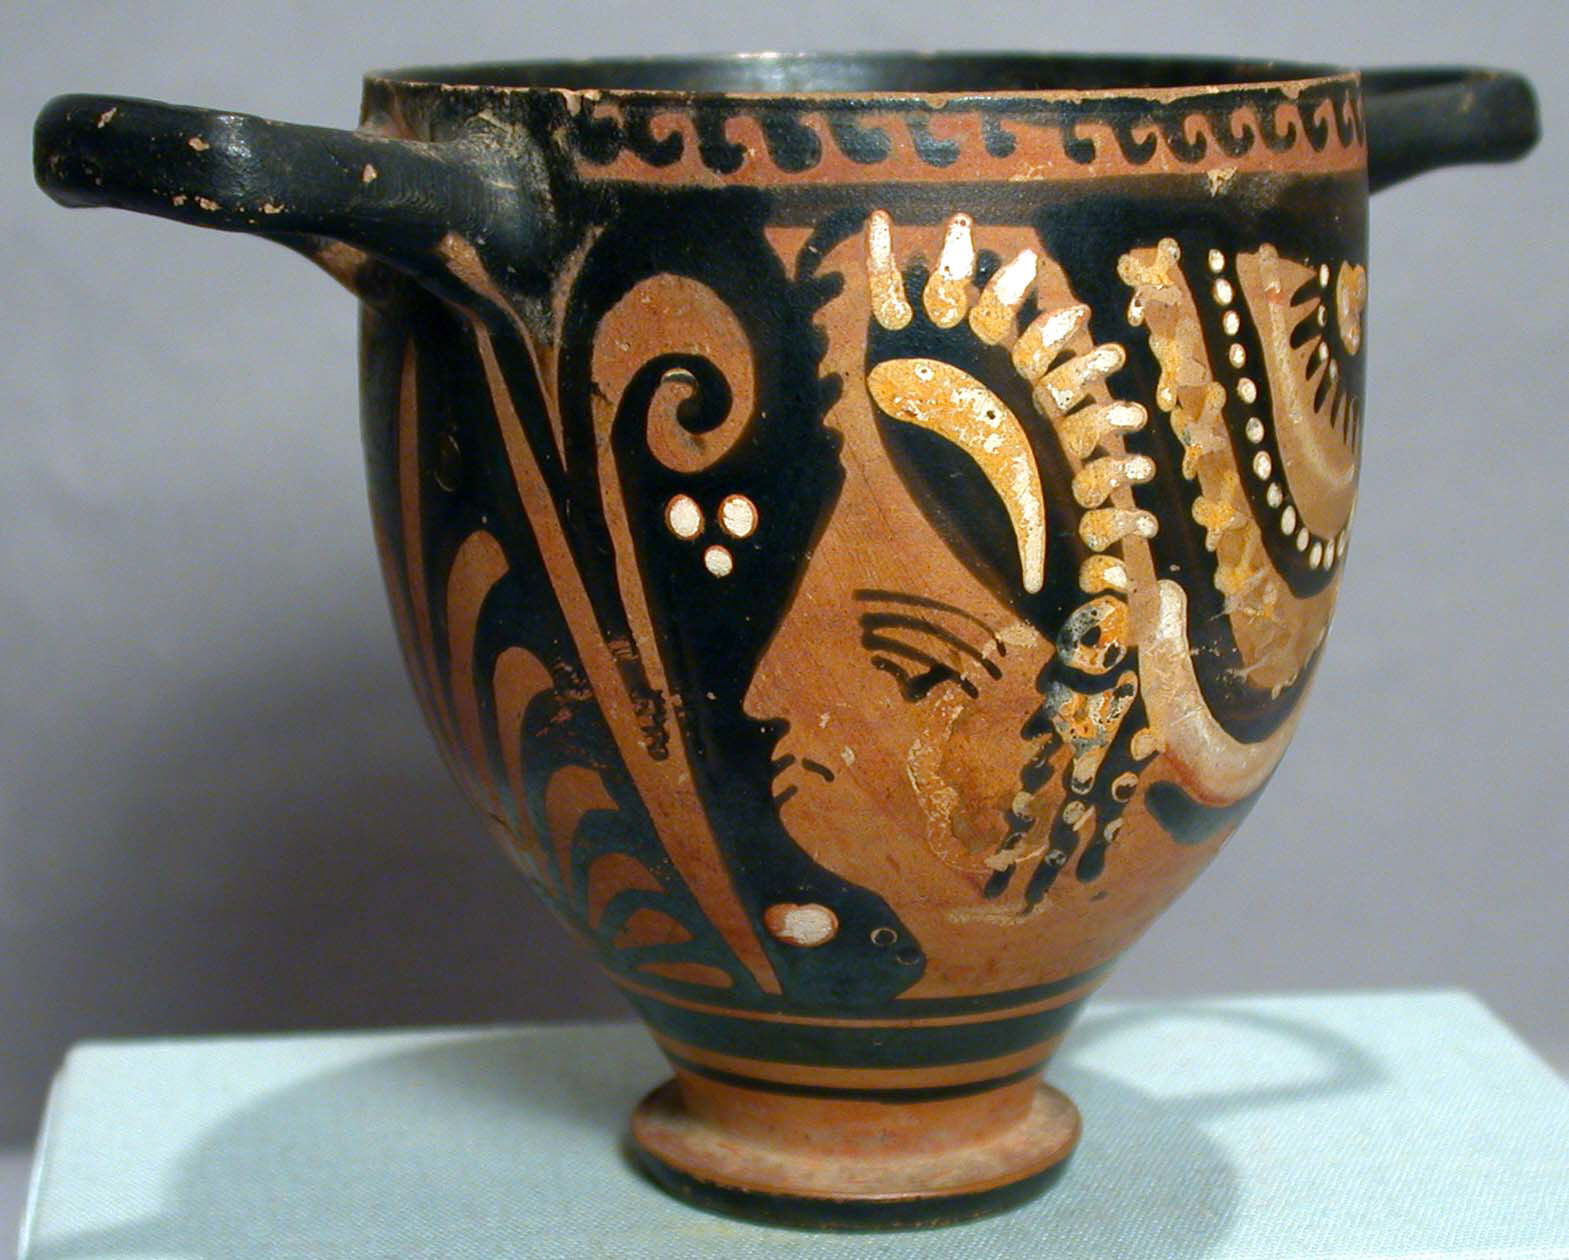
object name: skyphos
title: Terracotta skyphos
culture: greek, south italian, apulian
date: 325-301 BCE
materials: terracotta